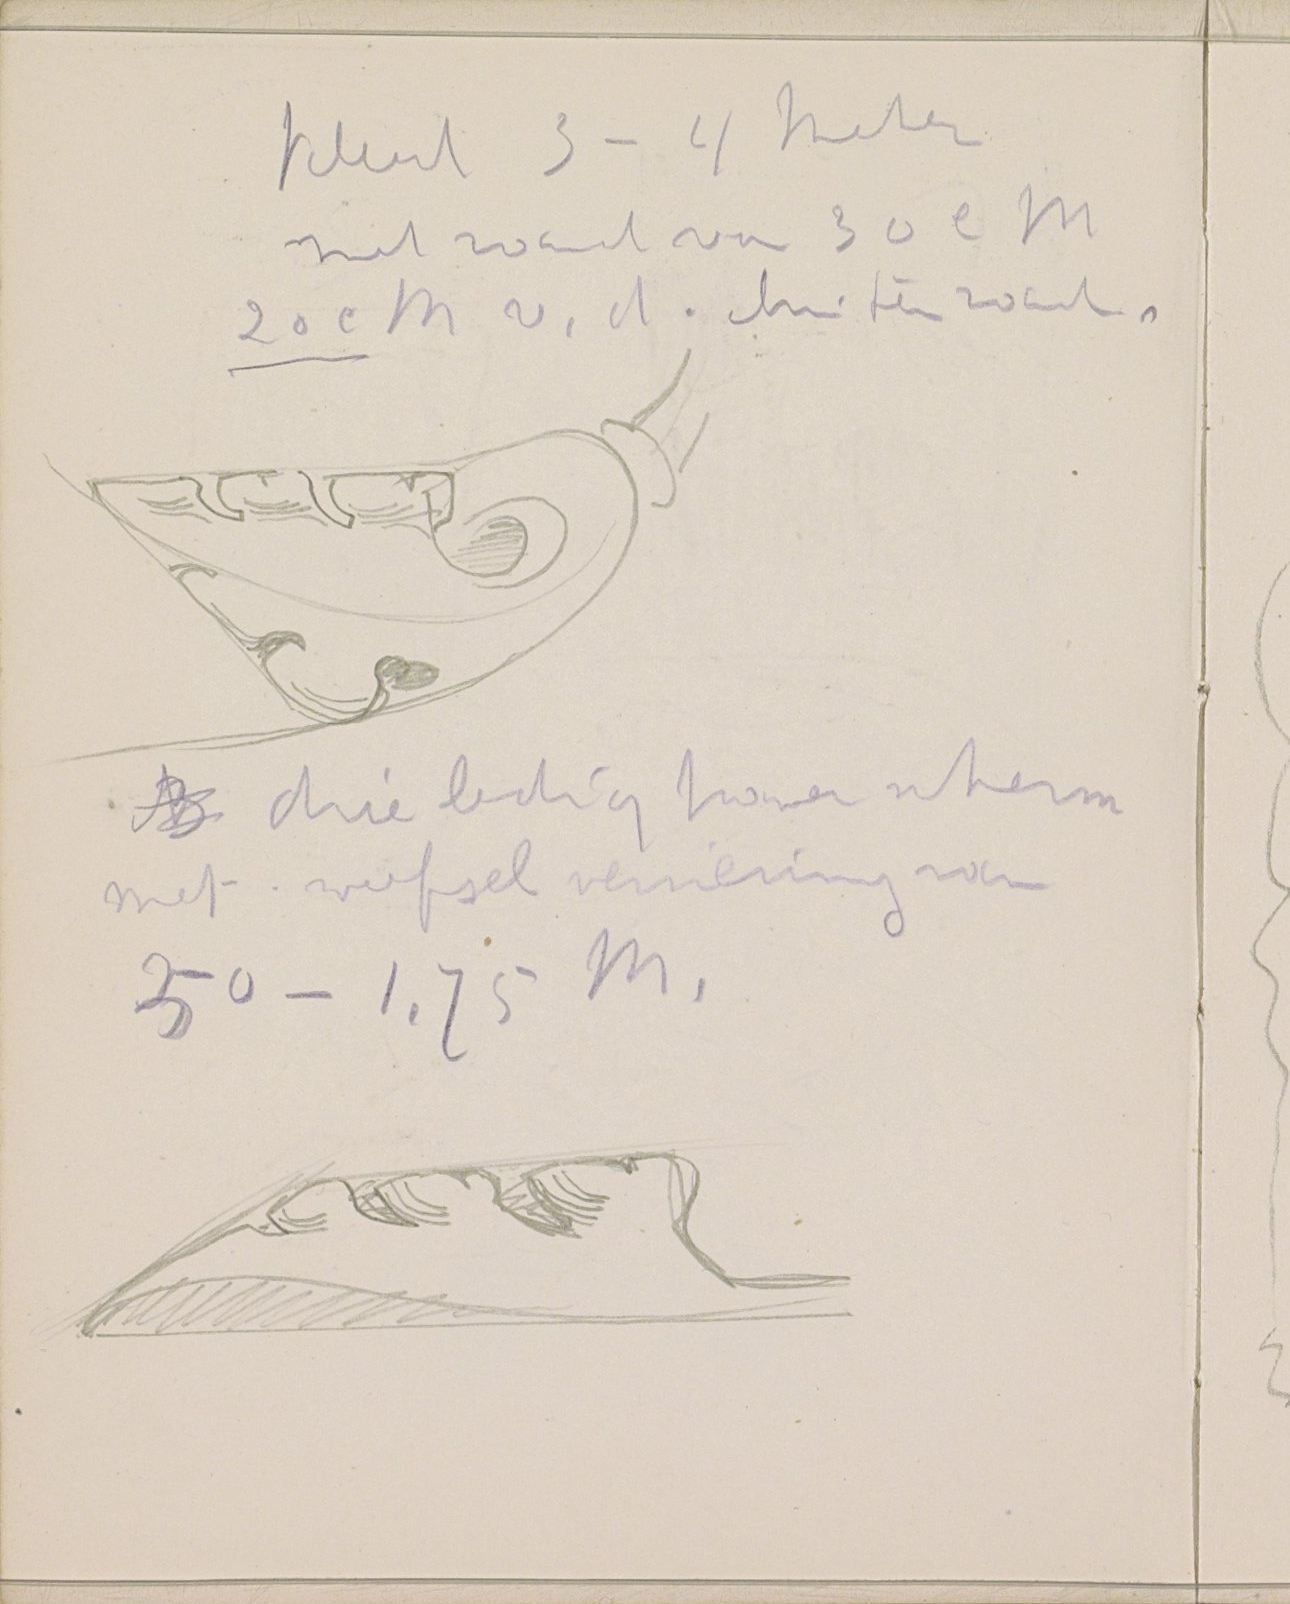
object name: sketchbook leaf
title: Ornamenten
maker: reijer stolk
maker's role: draughtsman, print maker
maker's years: 1896-1945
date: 1916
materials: paper, pencil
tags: ornaments ~ art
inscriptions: annotation: ‘[...]’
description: Blad 22 verso uit een schetsboek met 72 bladen.